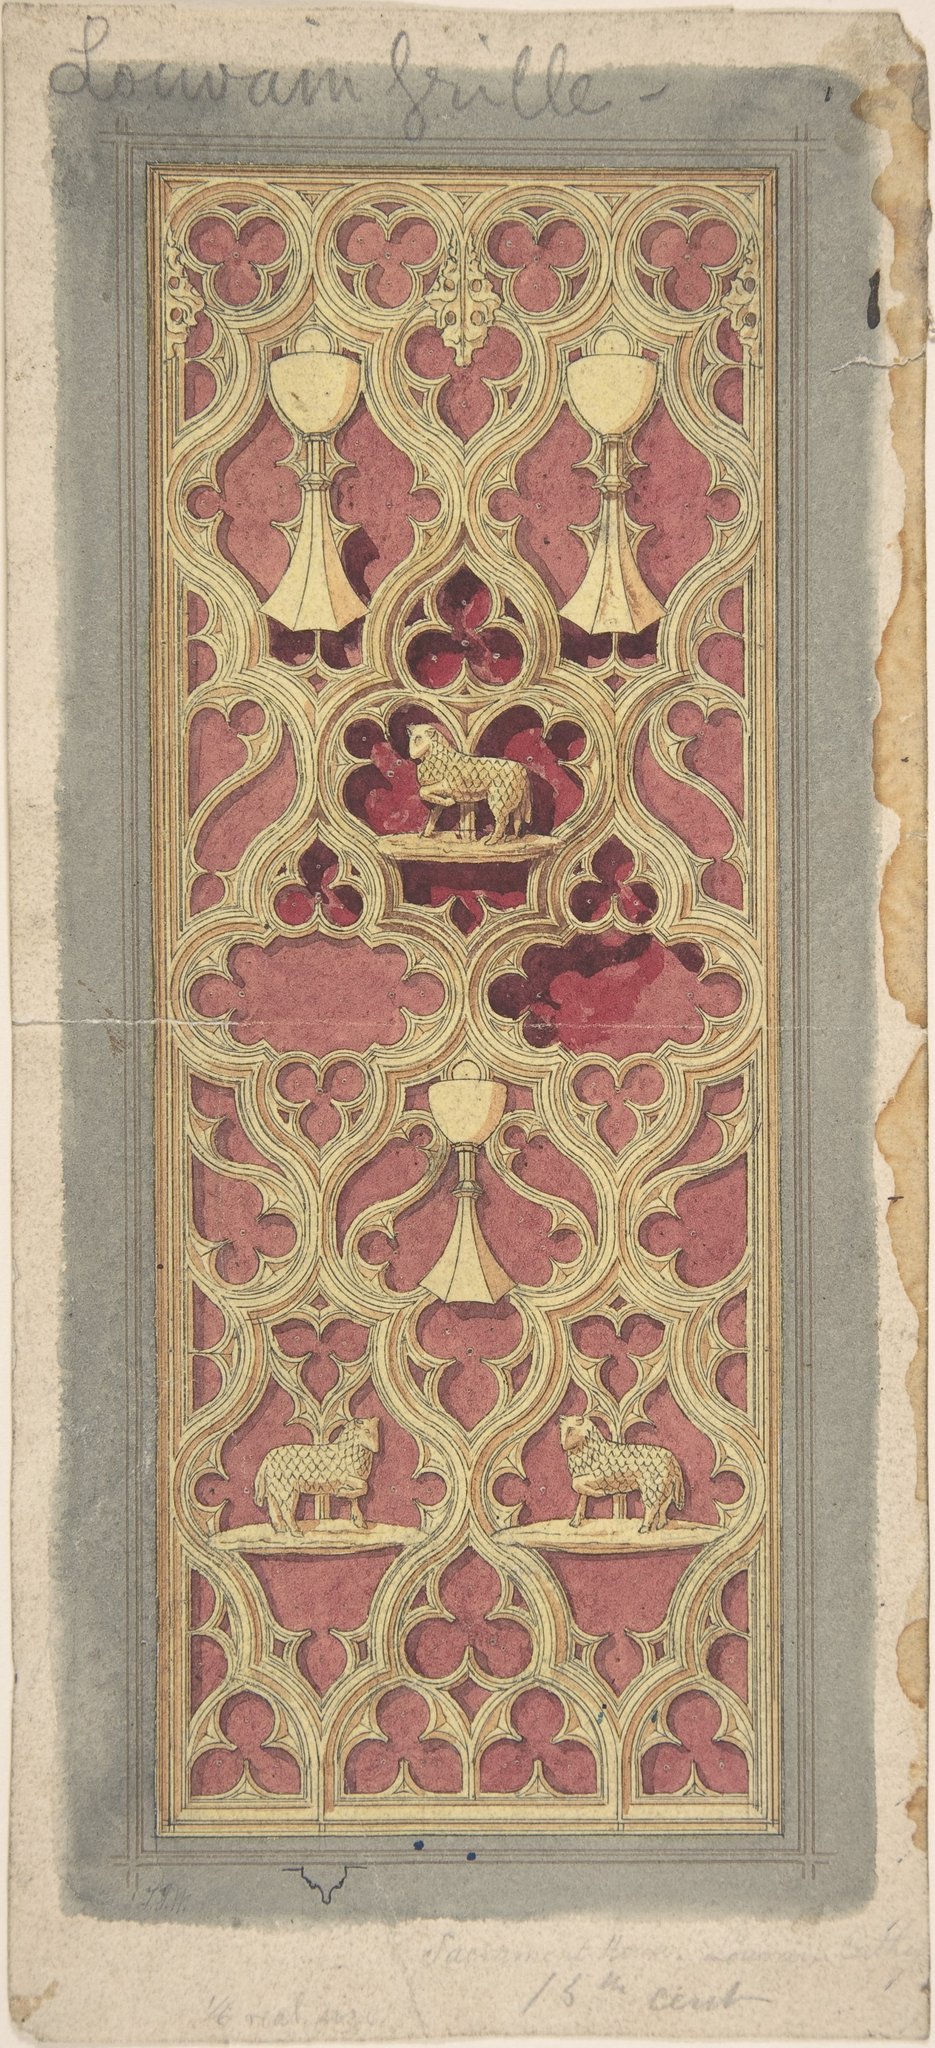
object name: drawing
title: Louvain Church Grille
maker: anonymous, british, 19th century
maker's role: artist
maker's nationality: british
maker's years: 1800-1900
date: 1851-1900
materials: ink, watercolor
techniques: pen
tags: animals